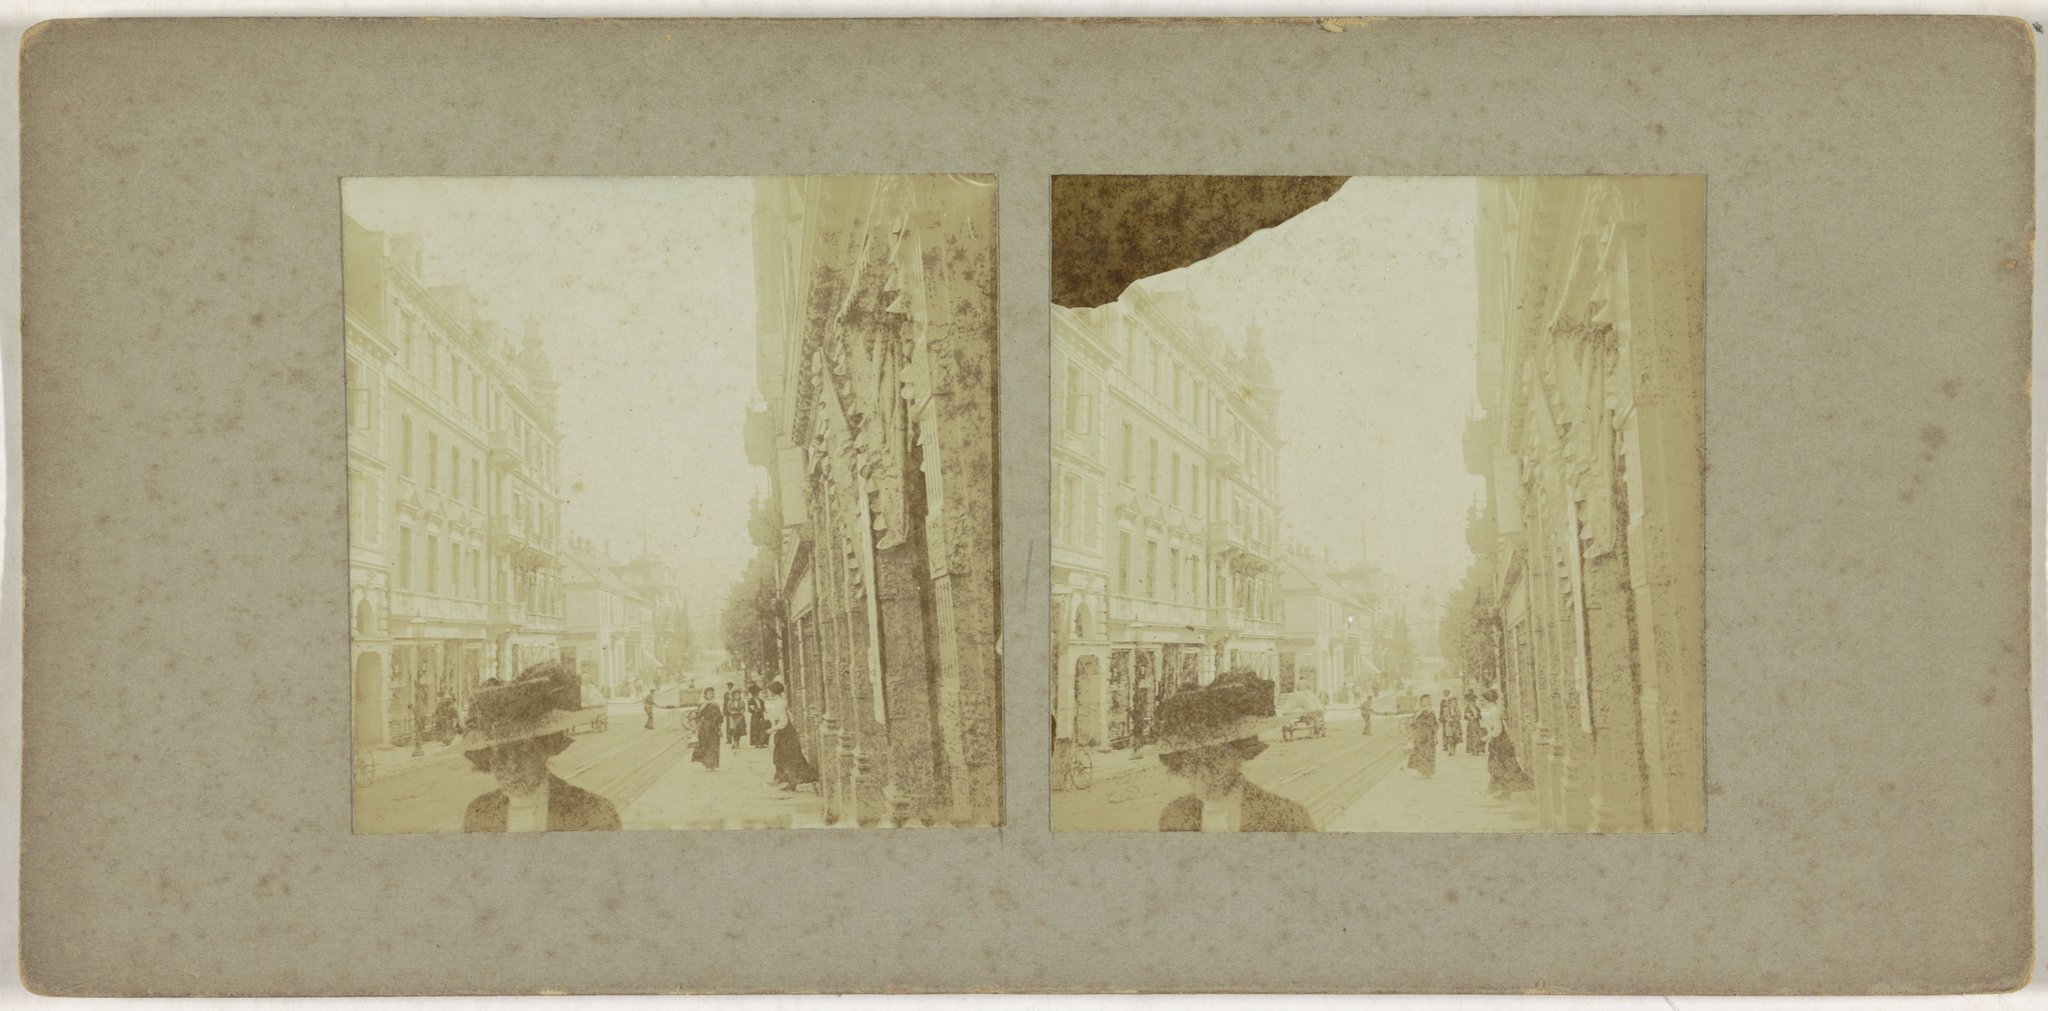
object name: stereograph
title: Straatbeeld in Bergen, Noorwegen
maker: Anonymous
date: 1882-1890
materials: paper, cardboard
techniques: gelatin silver print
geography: bergen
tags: street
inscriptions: inscription: ‘Bergen’